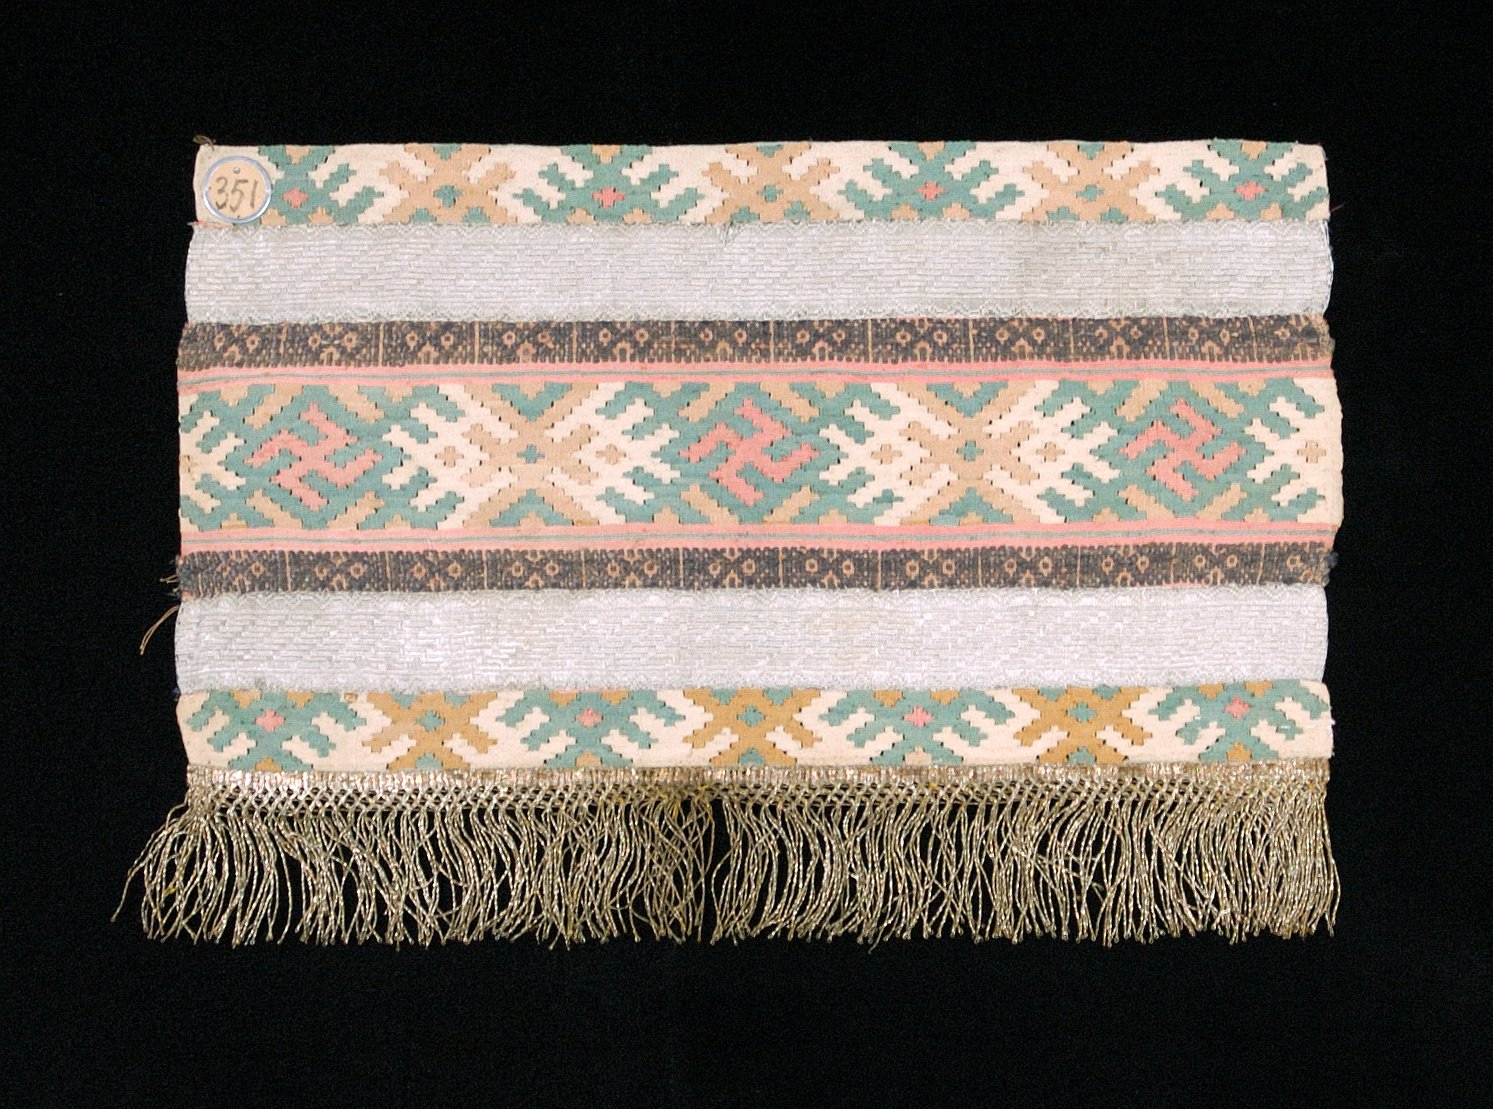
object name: textile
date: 1840-1870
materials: silk